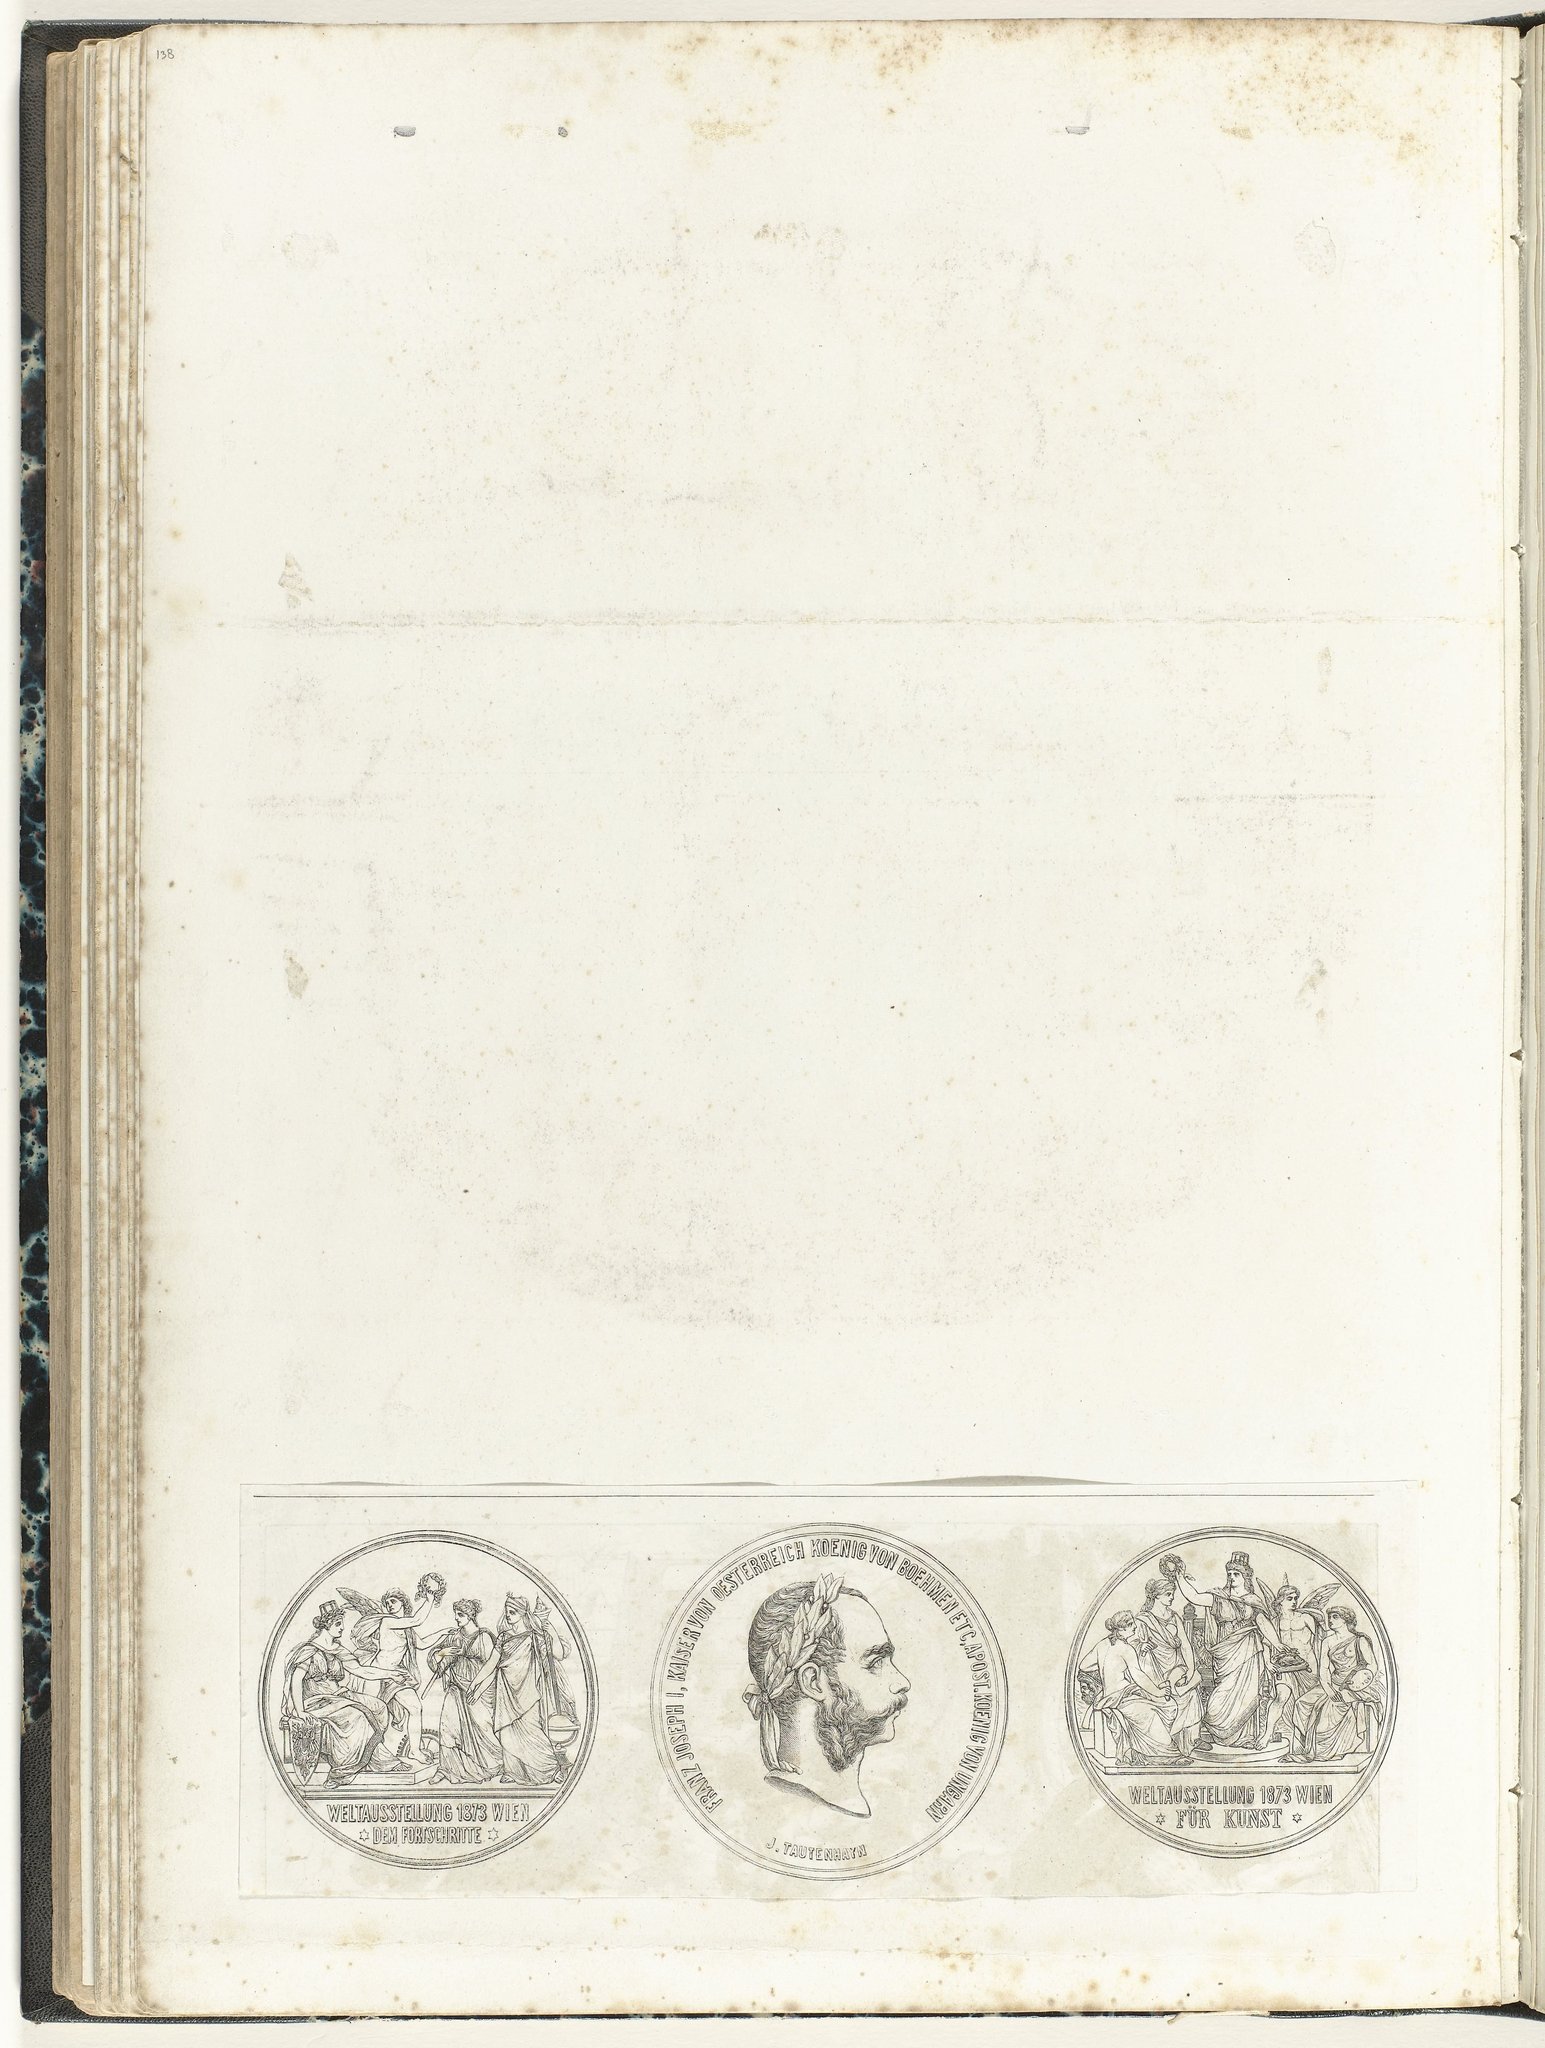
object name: print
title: Drie bekroningsmedailles voor de wereldtentoonstelling van 1873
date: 1873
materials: paper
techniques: engraving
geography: austria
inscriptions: date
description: Op de medaille in het midden staat een portret van Franz Joseph I.